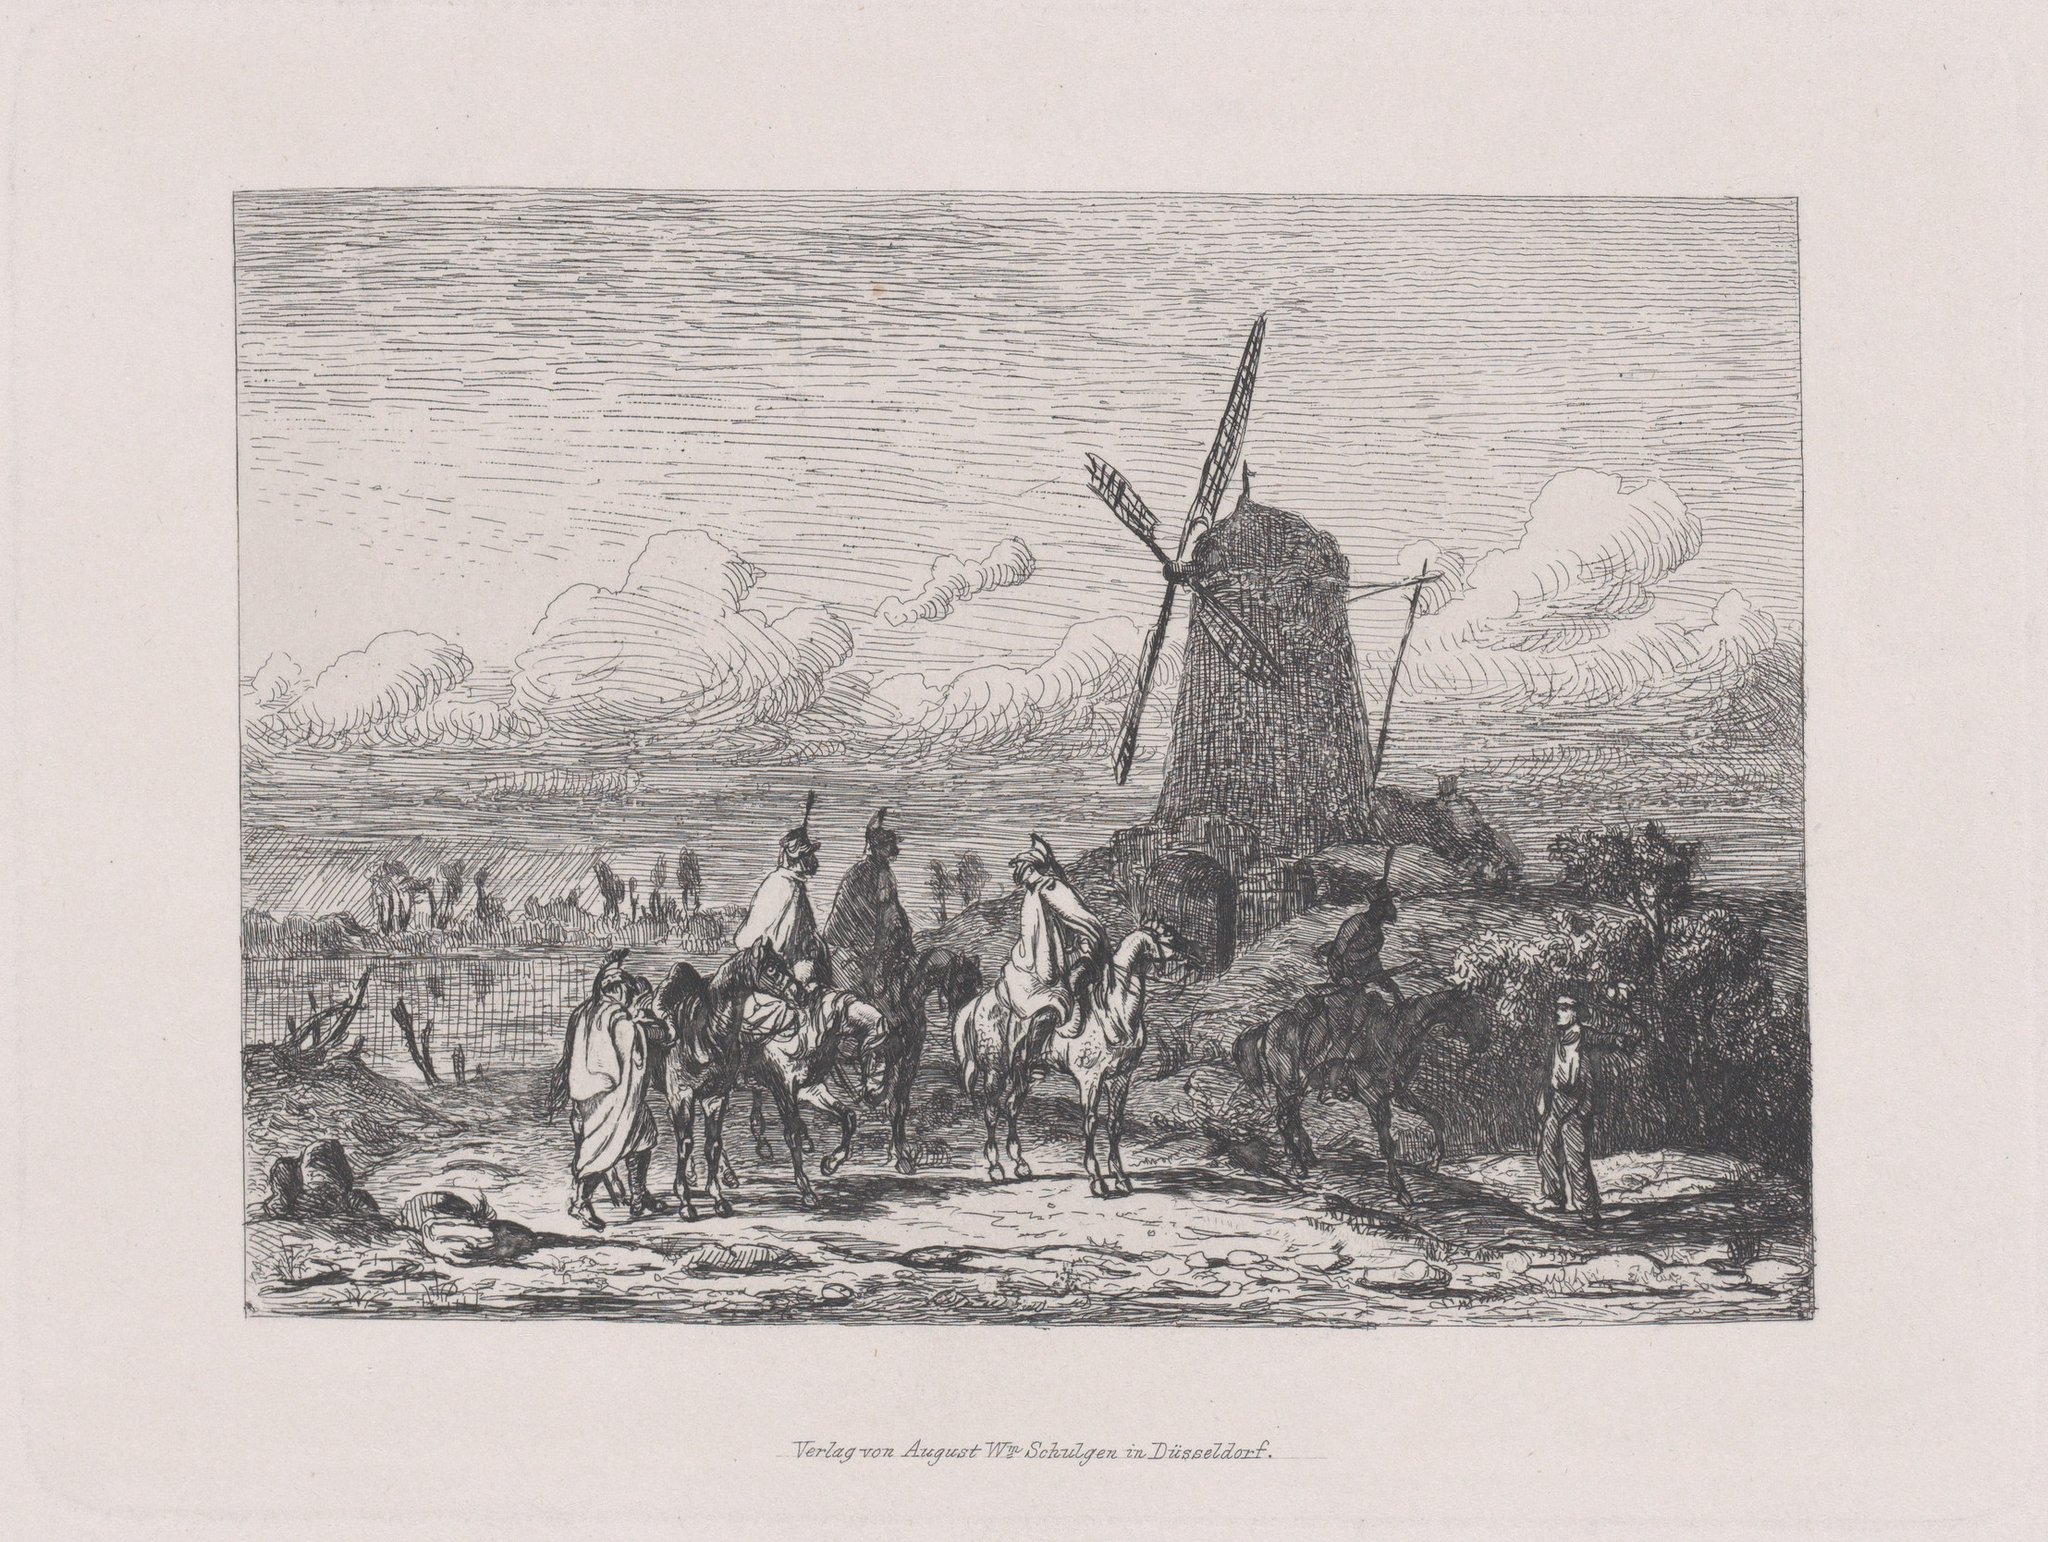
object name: print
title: Military scene with horsemen and a windmill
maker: august beck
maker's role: artist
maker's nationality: swiss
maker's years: 1823-1872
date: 1840-1860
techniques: etching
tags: windmills,men,horses